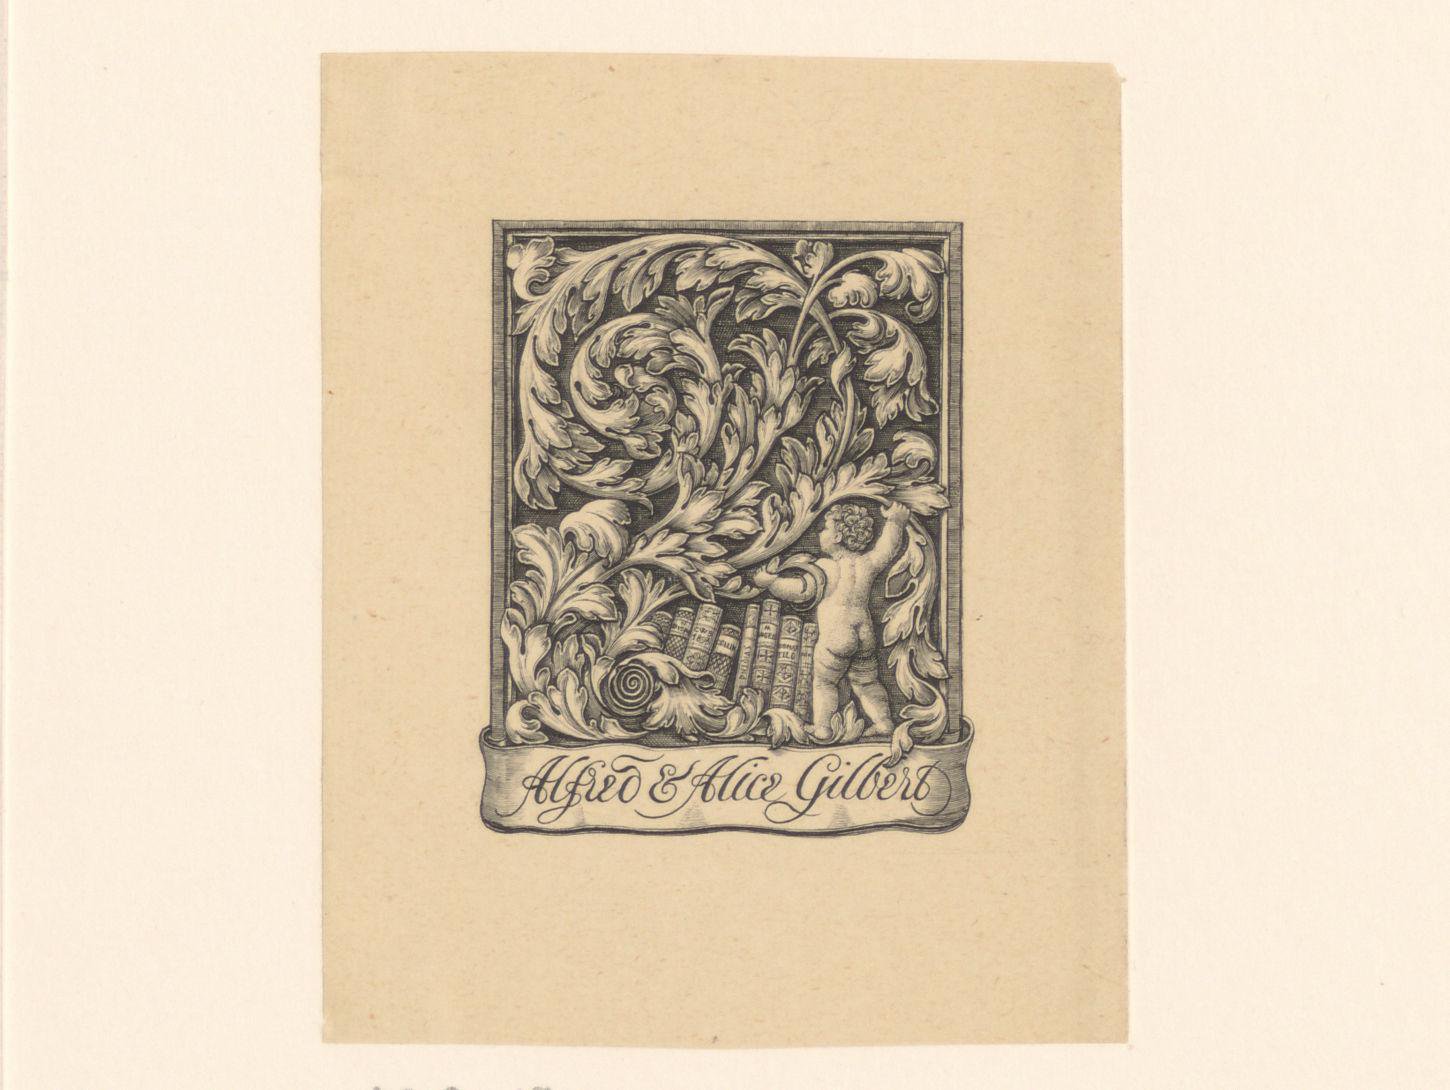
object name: bookplate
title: Ex libris van Alfred Gilbert en Alice Jane Gilbert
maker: charles william sherborn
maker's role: print maker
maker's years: 1831-1912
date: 1893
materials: paper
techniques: engraving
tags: foliage ~ ornament, book, cupids: 'amores', 'amoretti', 'putti'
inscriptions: collector's mark: Lugt 2228